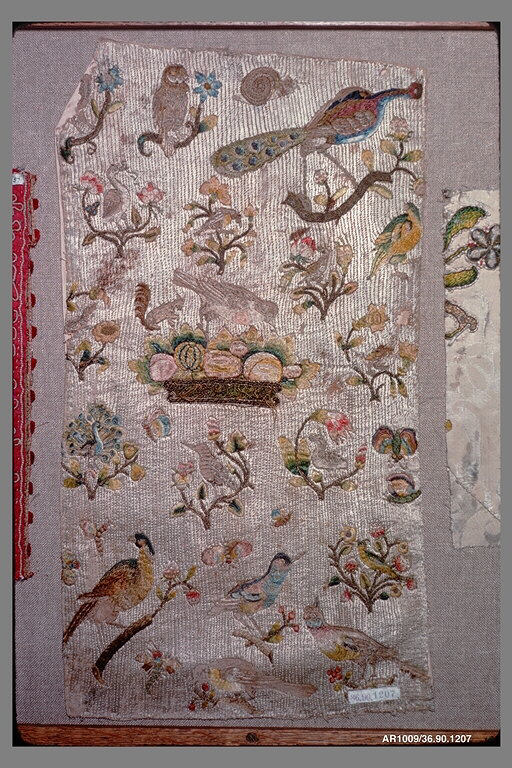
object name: piece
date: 1701-1900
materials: linen, metal thread, silk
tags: birds,peacocks,squirrels,flowers